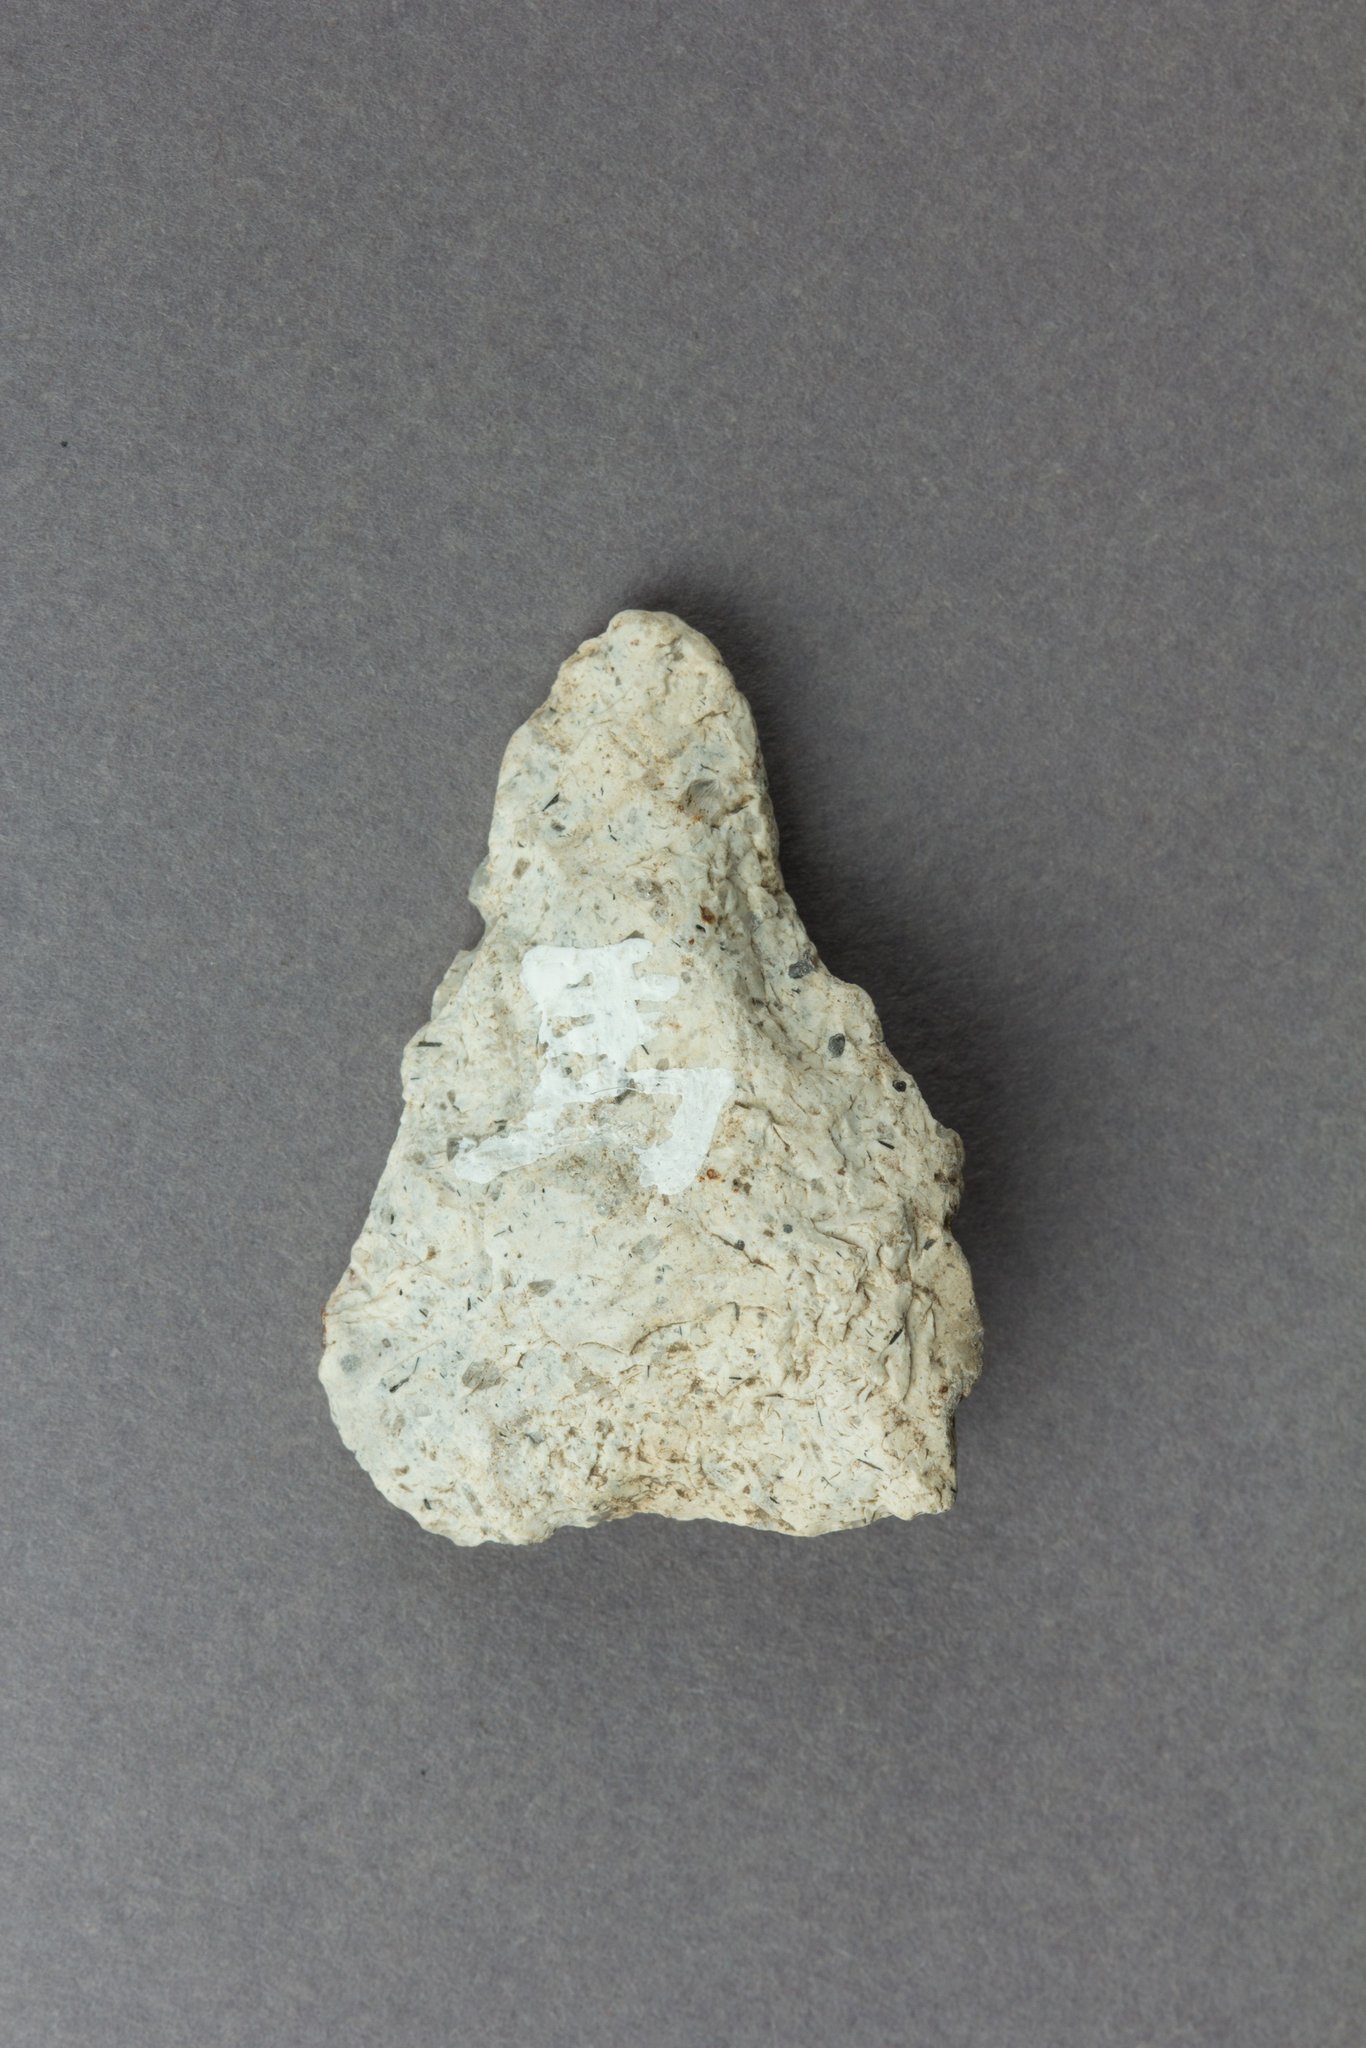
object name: arrowhead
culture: japanese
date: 1500-1000 BCE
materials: stone